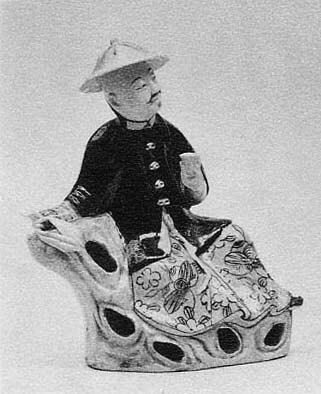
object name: figure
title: Figure of Seated Gentleman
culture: chinese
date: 1667-1733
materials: biscuit, enamel, porcelain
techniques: painting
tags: men